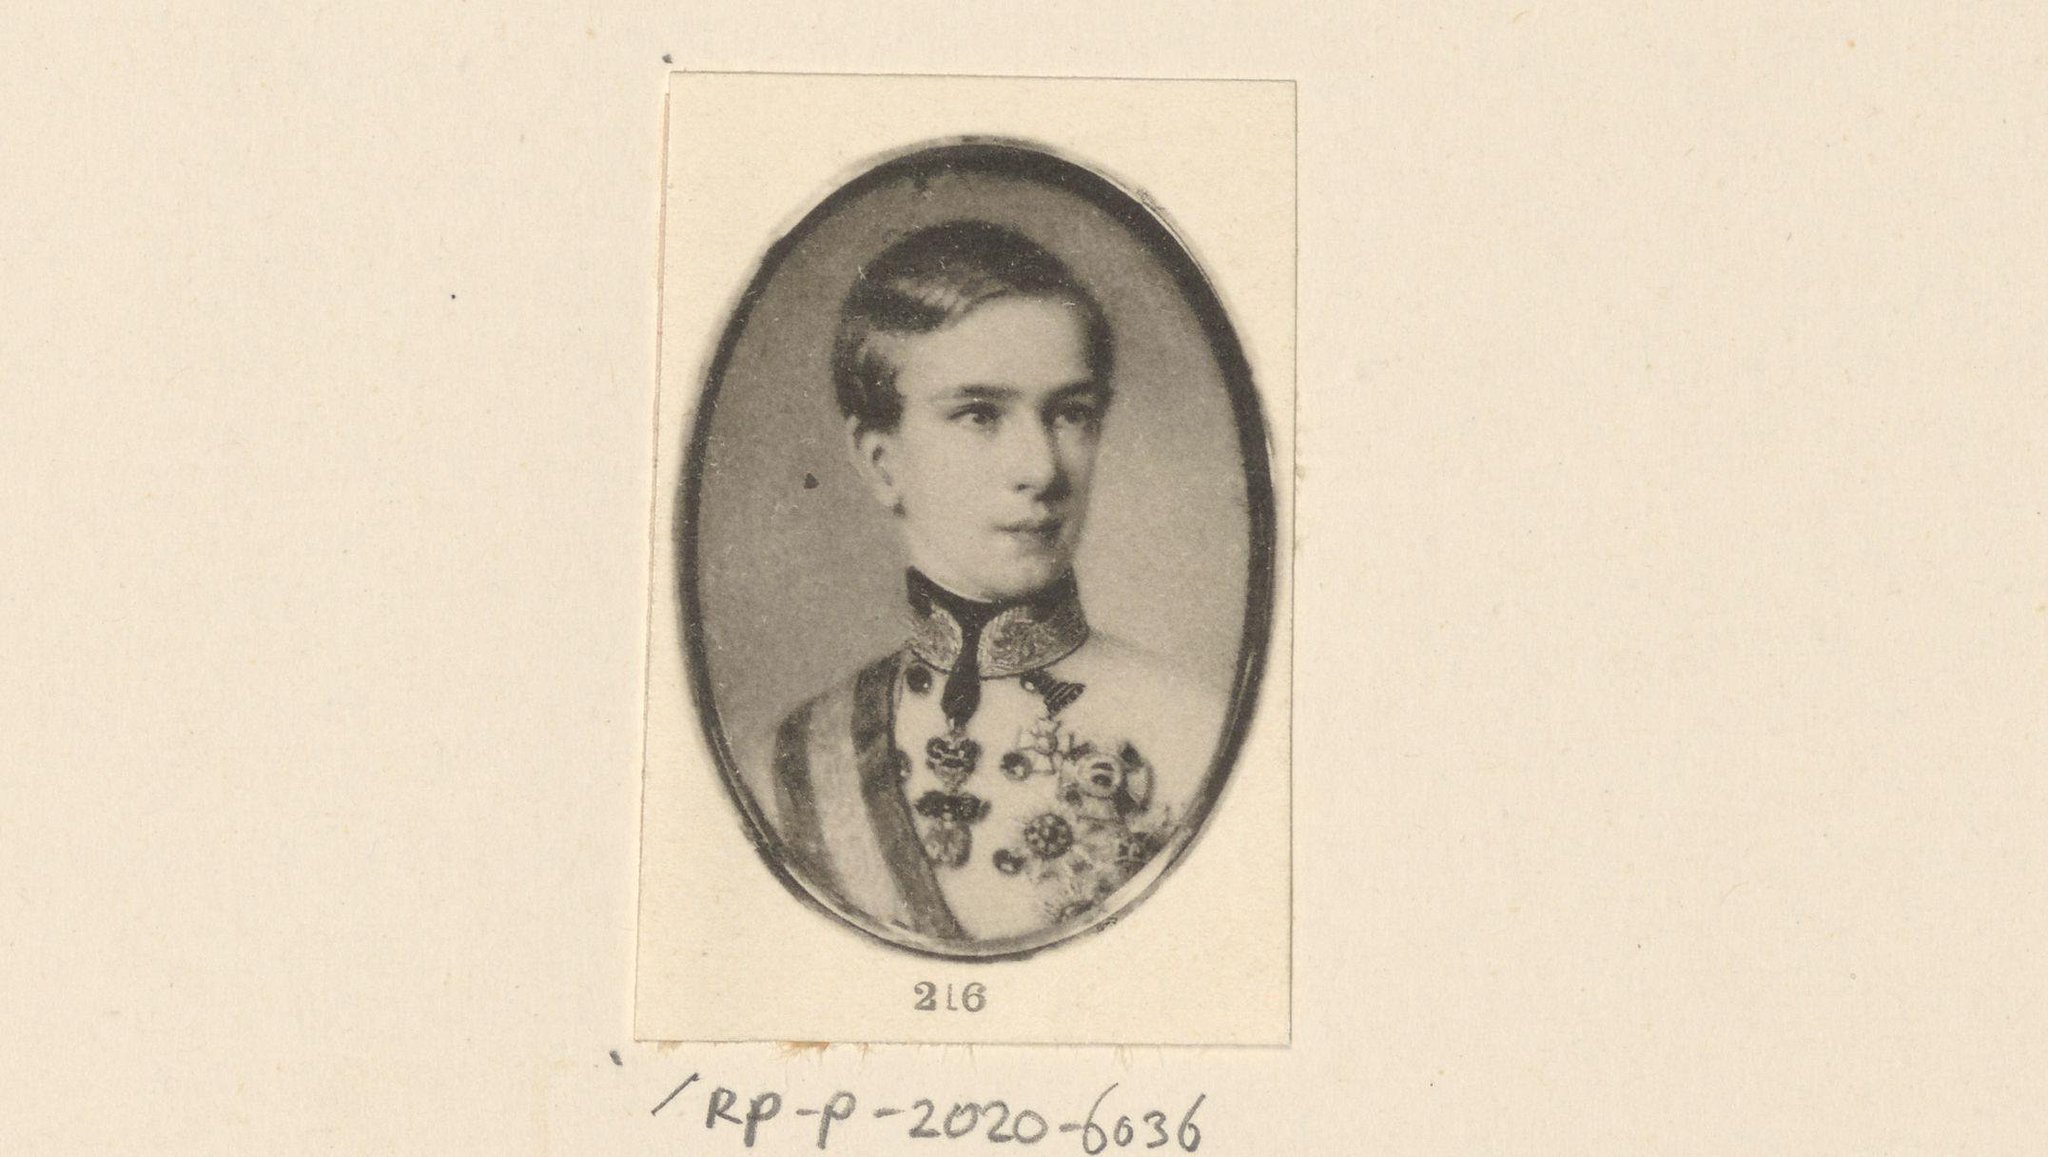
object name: photomechanical print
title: Portret van Frans Jozef I van Oostenrijk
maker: Anonymous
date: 1875-1930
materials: paper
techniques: photograph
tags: vienna, historical persons, emperor